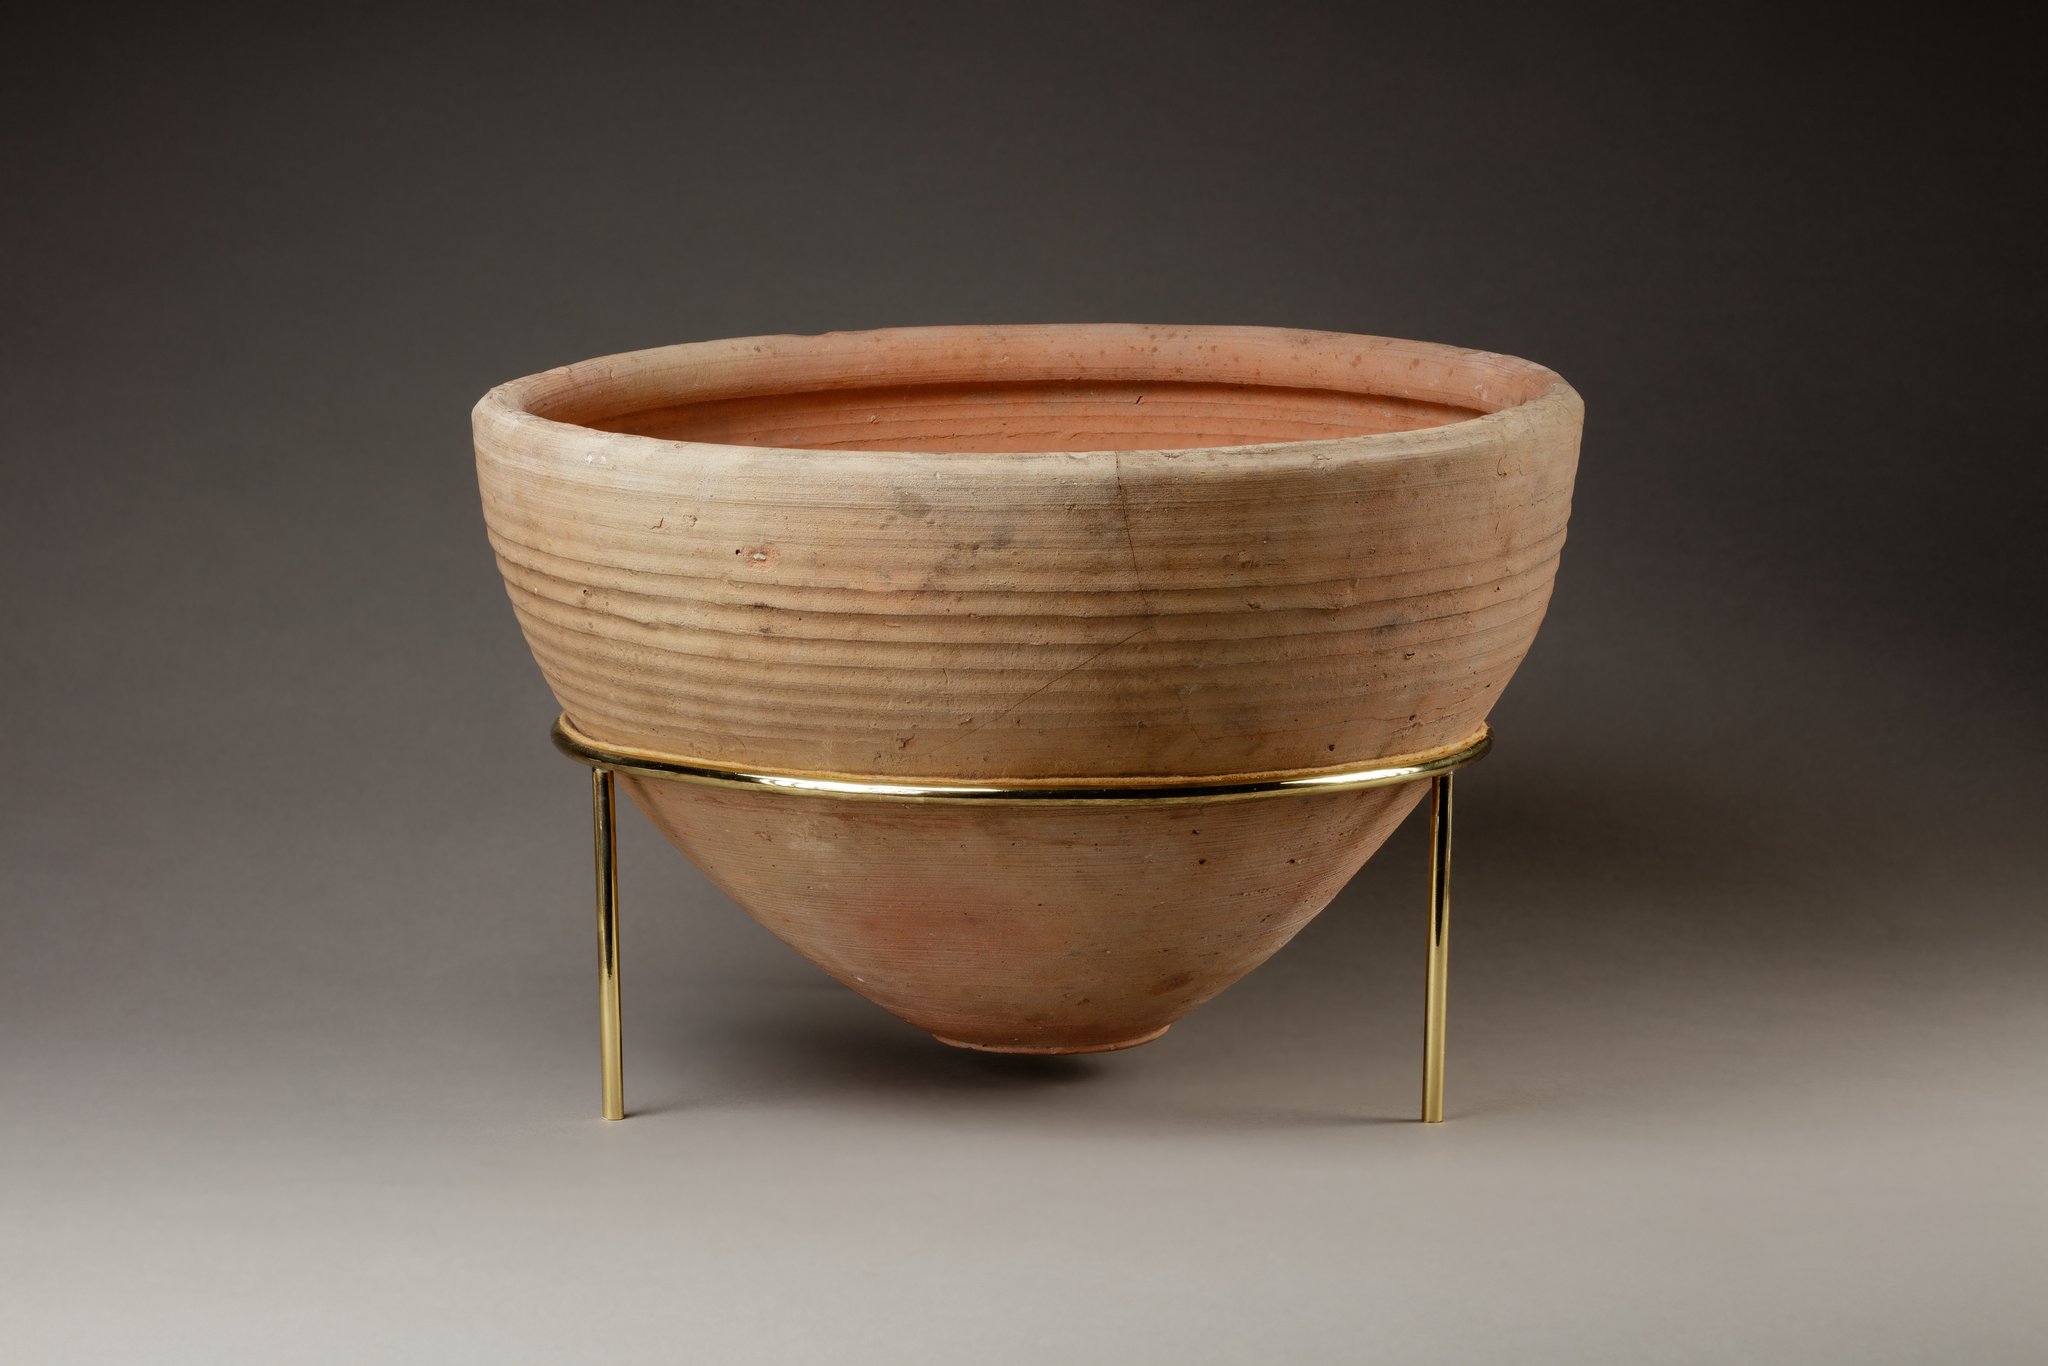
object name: bowl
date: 664-332 BCE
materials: pottery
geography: egypt